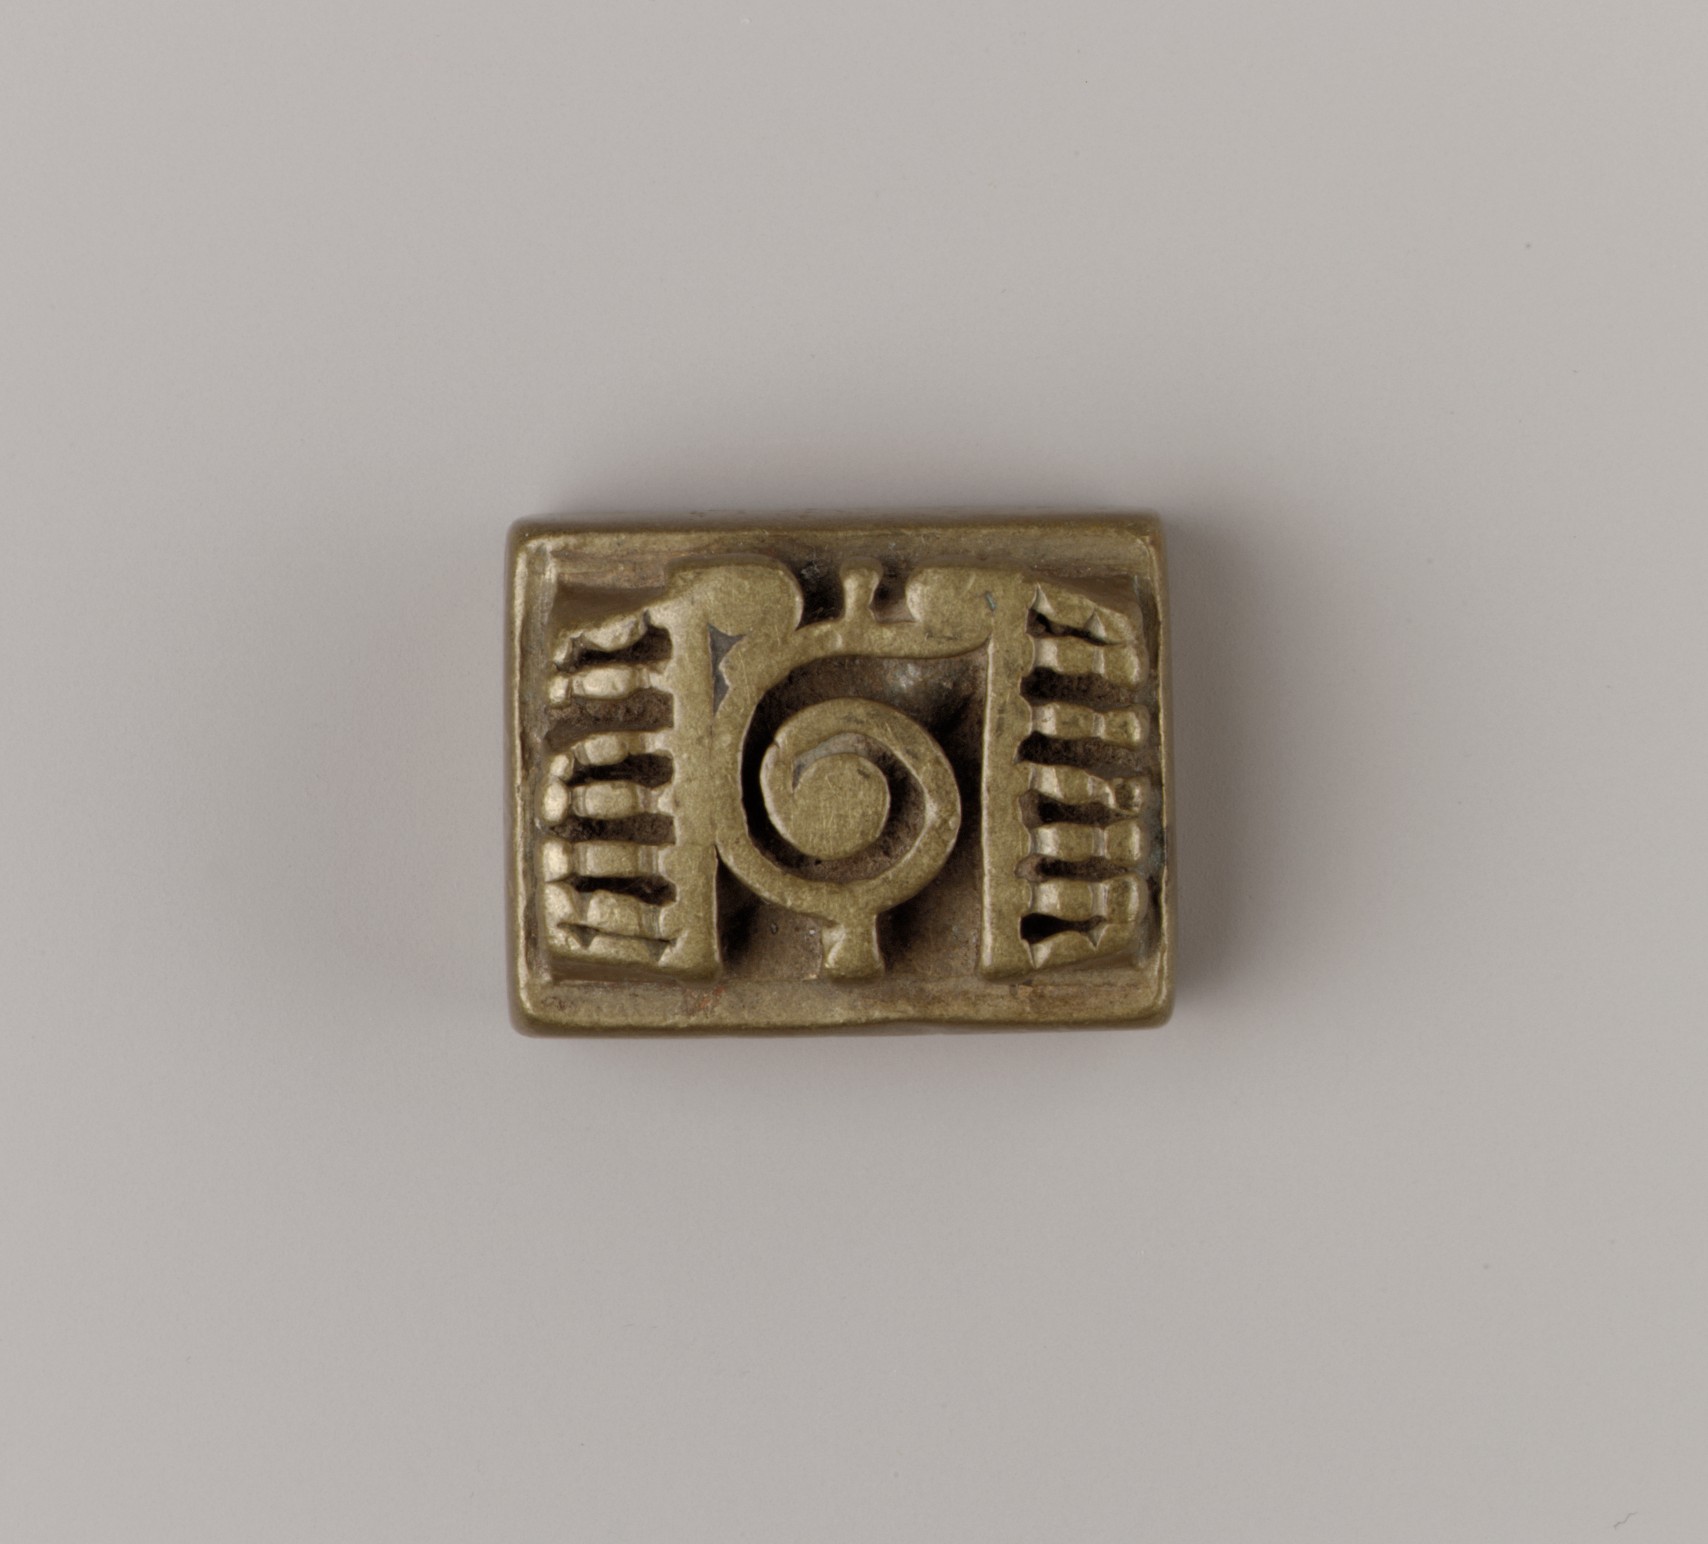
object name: weight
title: Geometric gold weight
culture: akan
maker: akan artist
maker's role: artist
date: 1501-1700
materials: brass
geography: côte d’ivoire